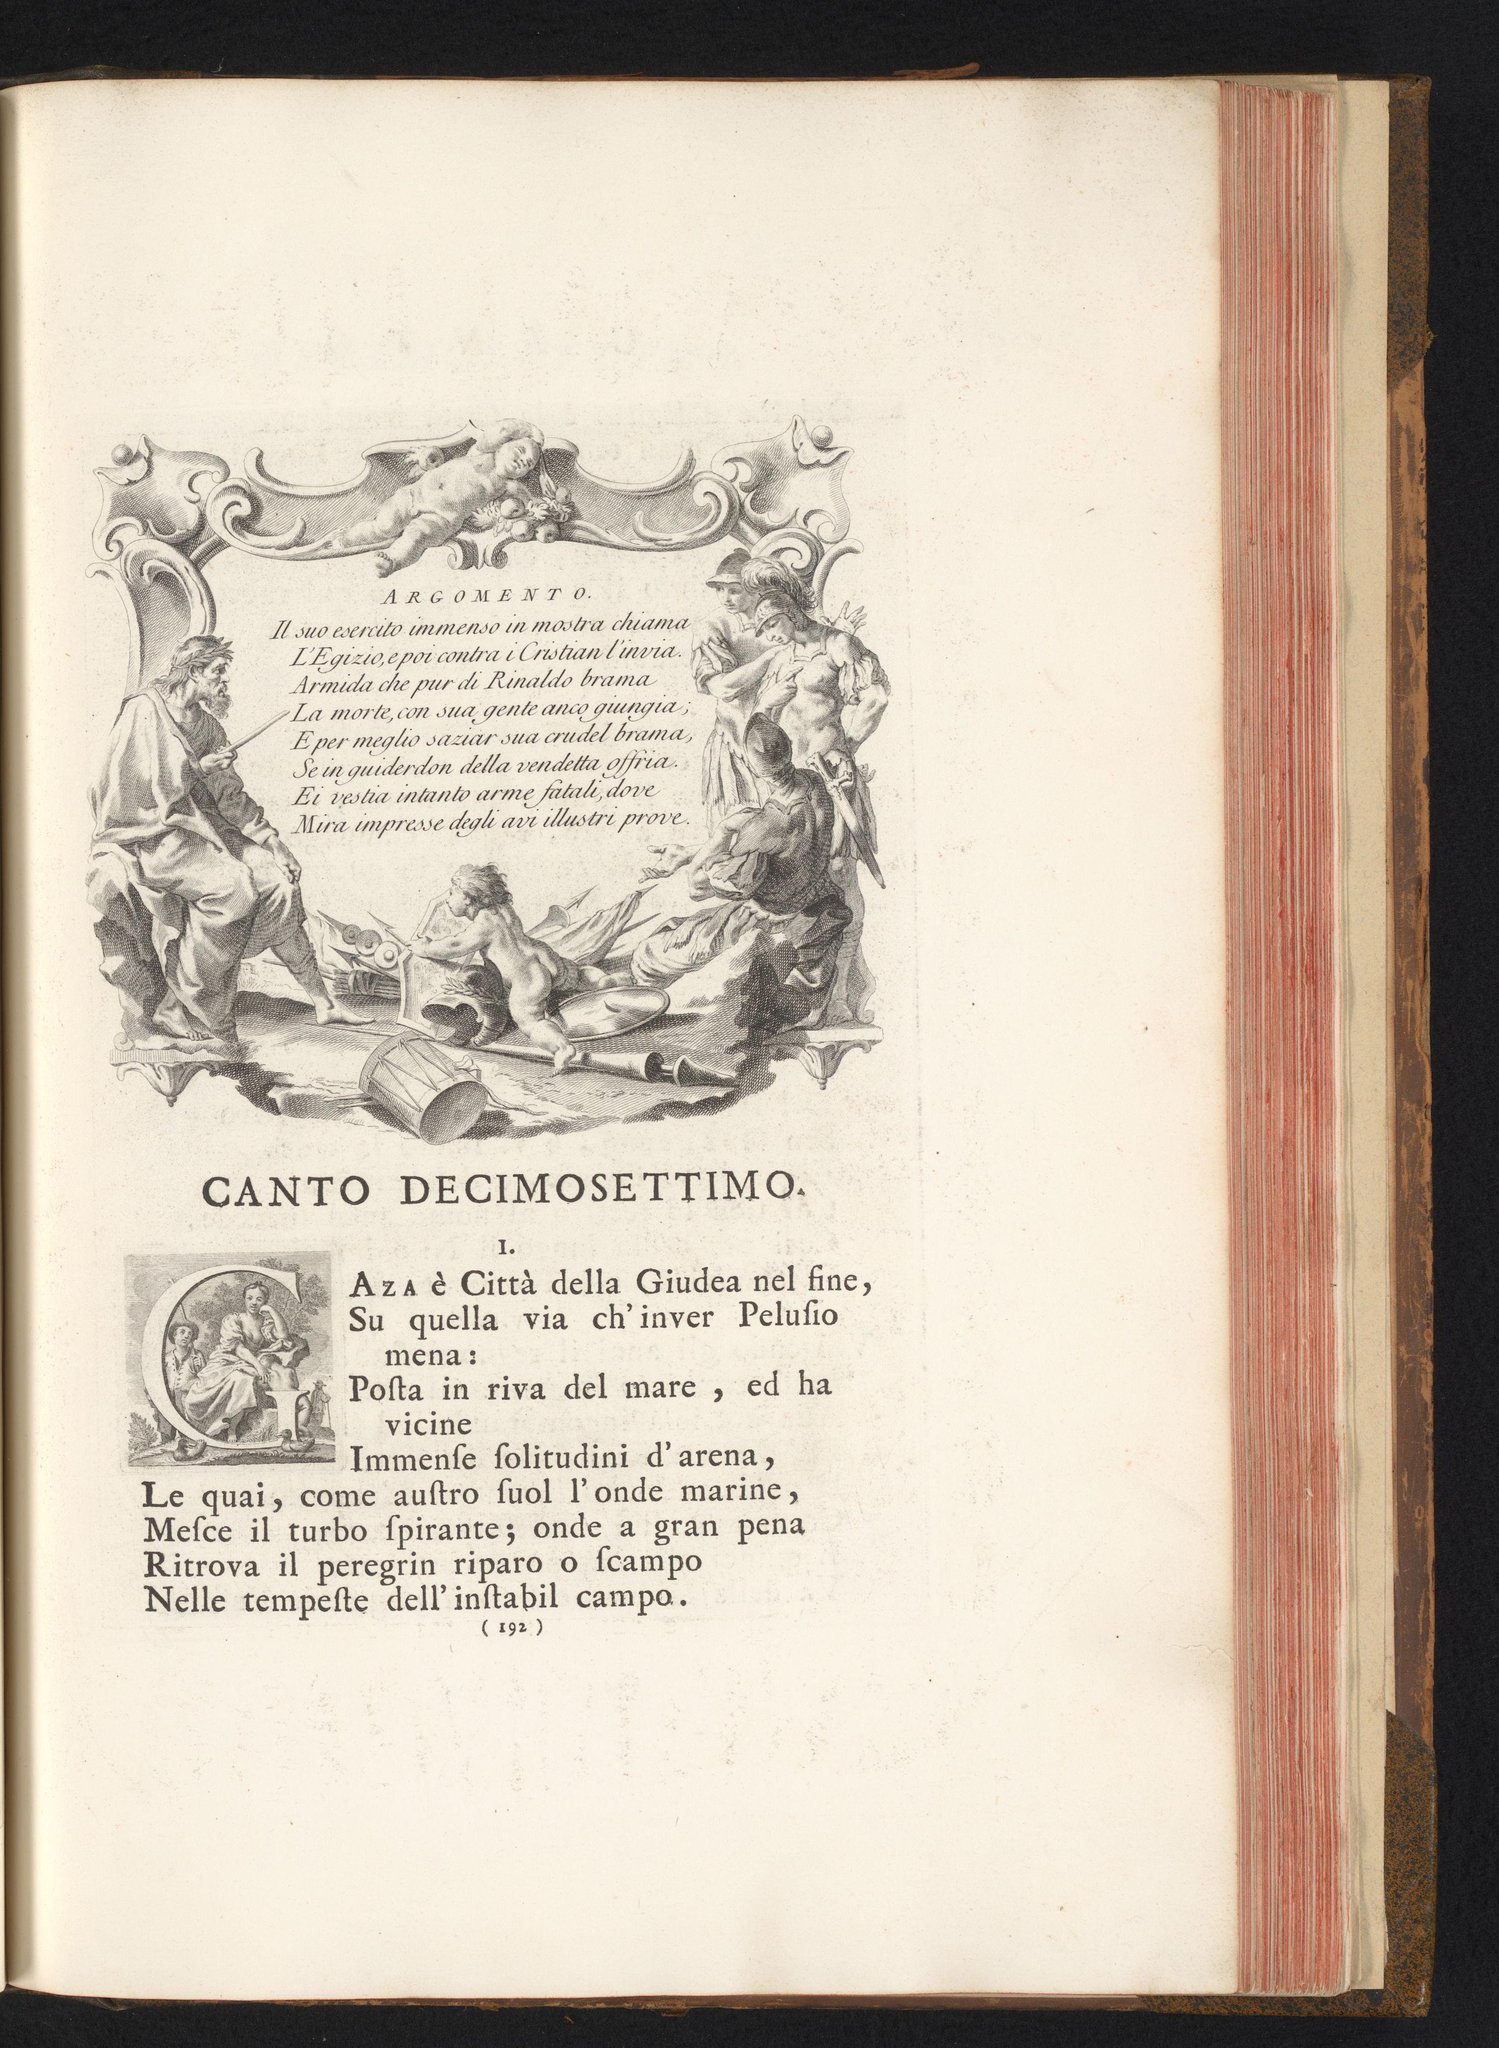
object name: print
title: Soldaten en een putto bij een oude man met lauwerkrans en initiaal G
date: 1745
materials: paper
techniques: etching, letterpress printing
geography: venice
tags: honouring the artist with laurel wreath, initial, (scenes from) specific works of literature: tasso, gerusalemme liberata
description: Prent uit: Tasso, Torquato. La Gerusalemme liberata di Torquato Tasso con le figure de Giambatista Piazzetta. Venetië: Giambatista Albrizzi, 1745.